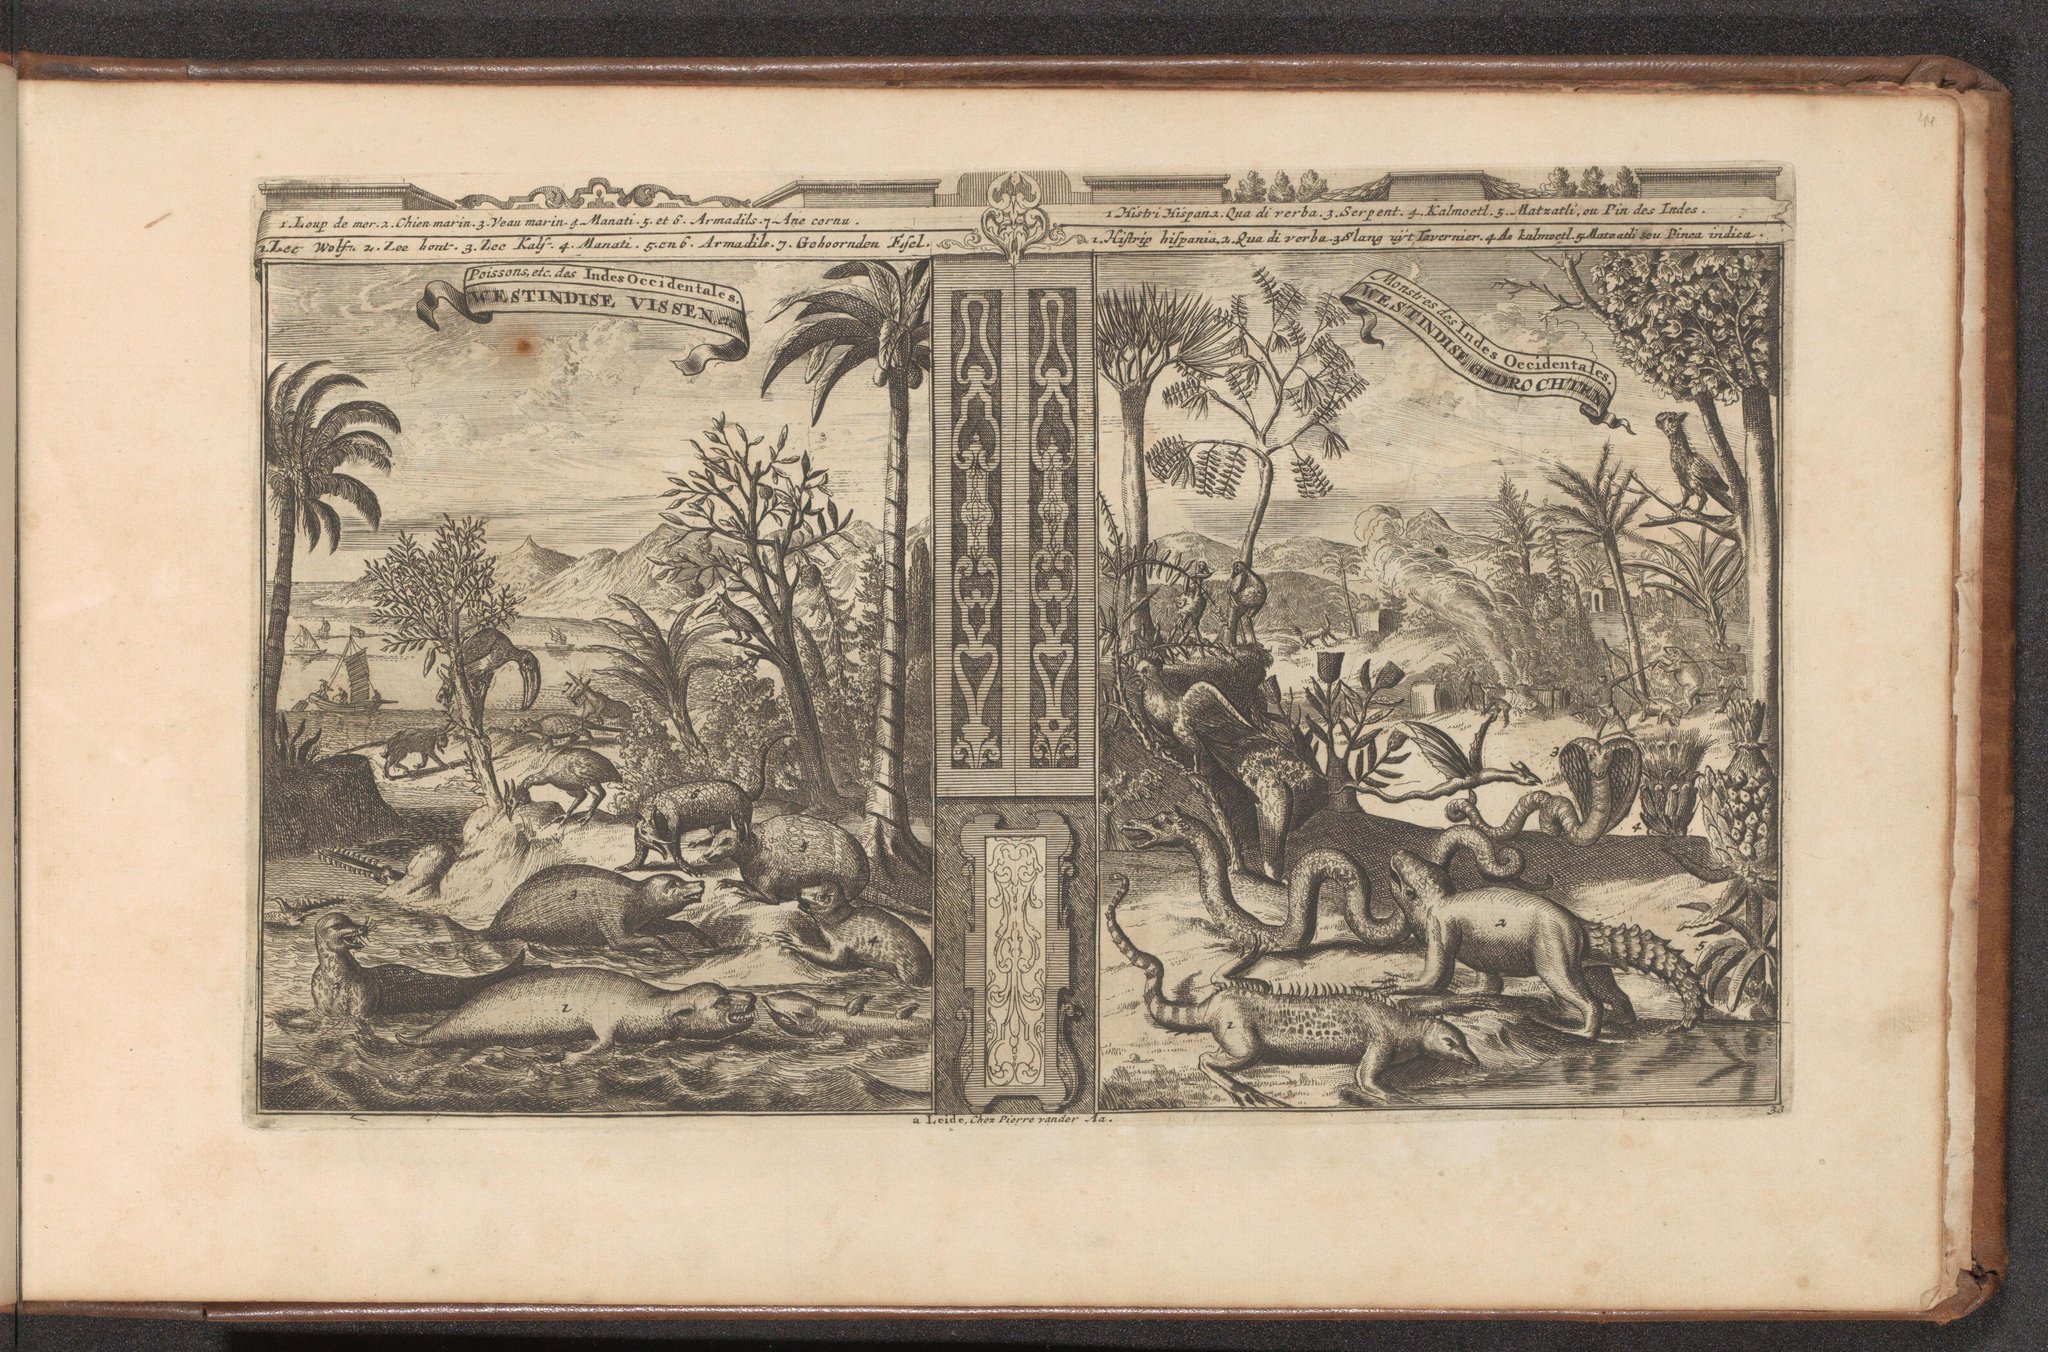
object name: print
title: Dieren uit West-Indië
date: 1682-1733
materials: paper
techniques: etching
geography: leiden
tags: animals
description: Voorstelling in twee delen. Zowel links als rechts een landschap met dieren uit West-Indië, onder meer een zeewolf, zeehond, armadil en enkele slangen. Rechts op de achtergrond wordt een dier aan een spit boven een vuur gebraden. Met een legenda in het Nederlands en het Frans. De prent maakt deel uit van een album.